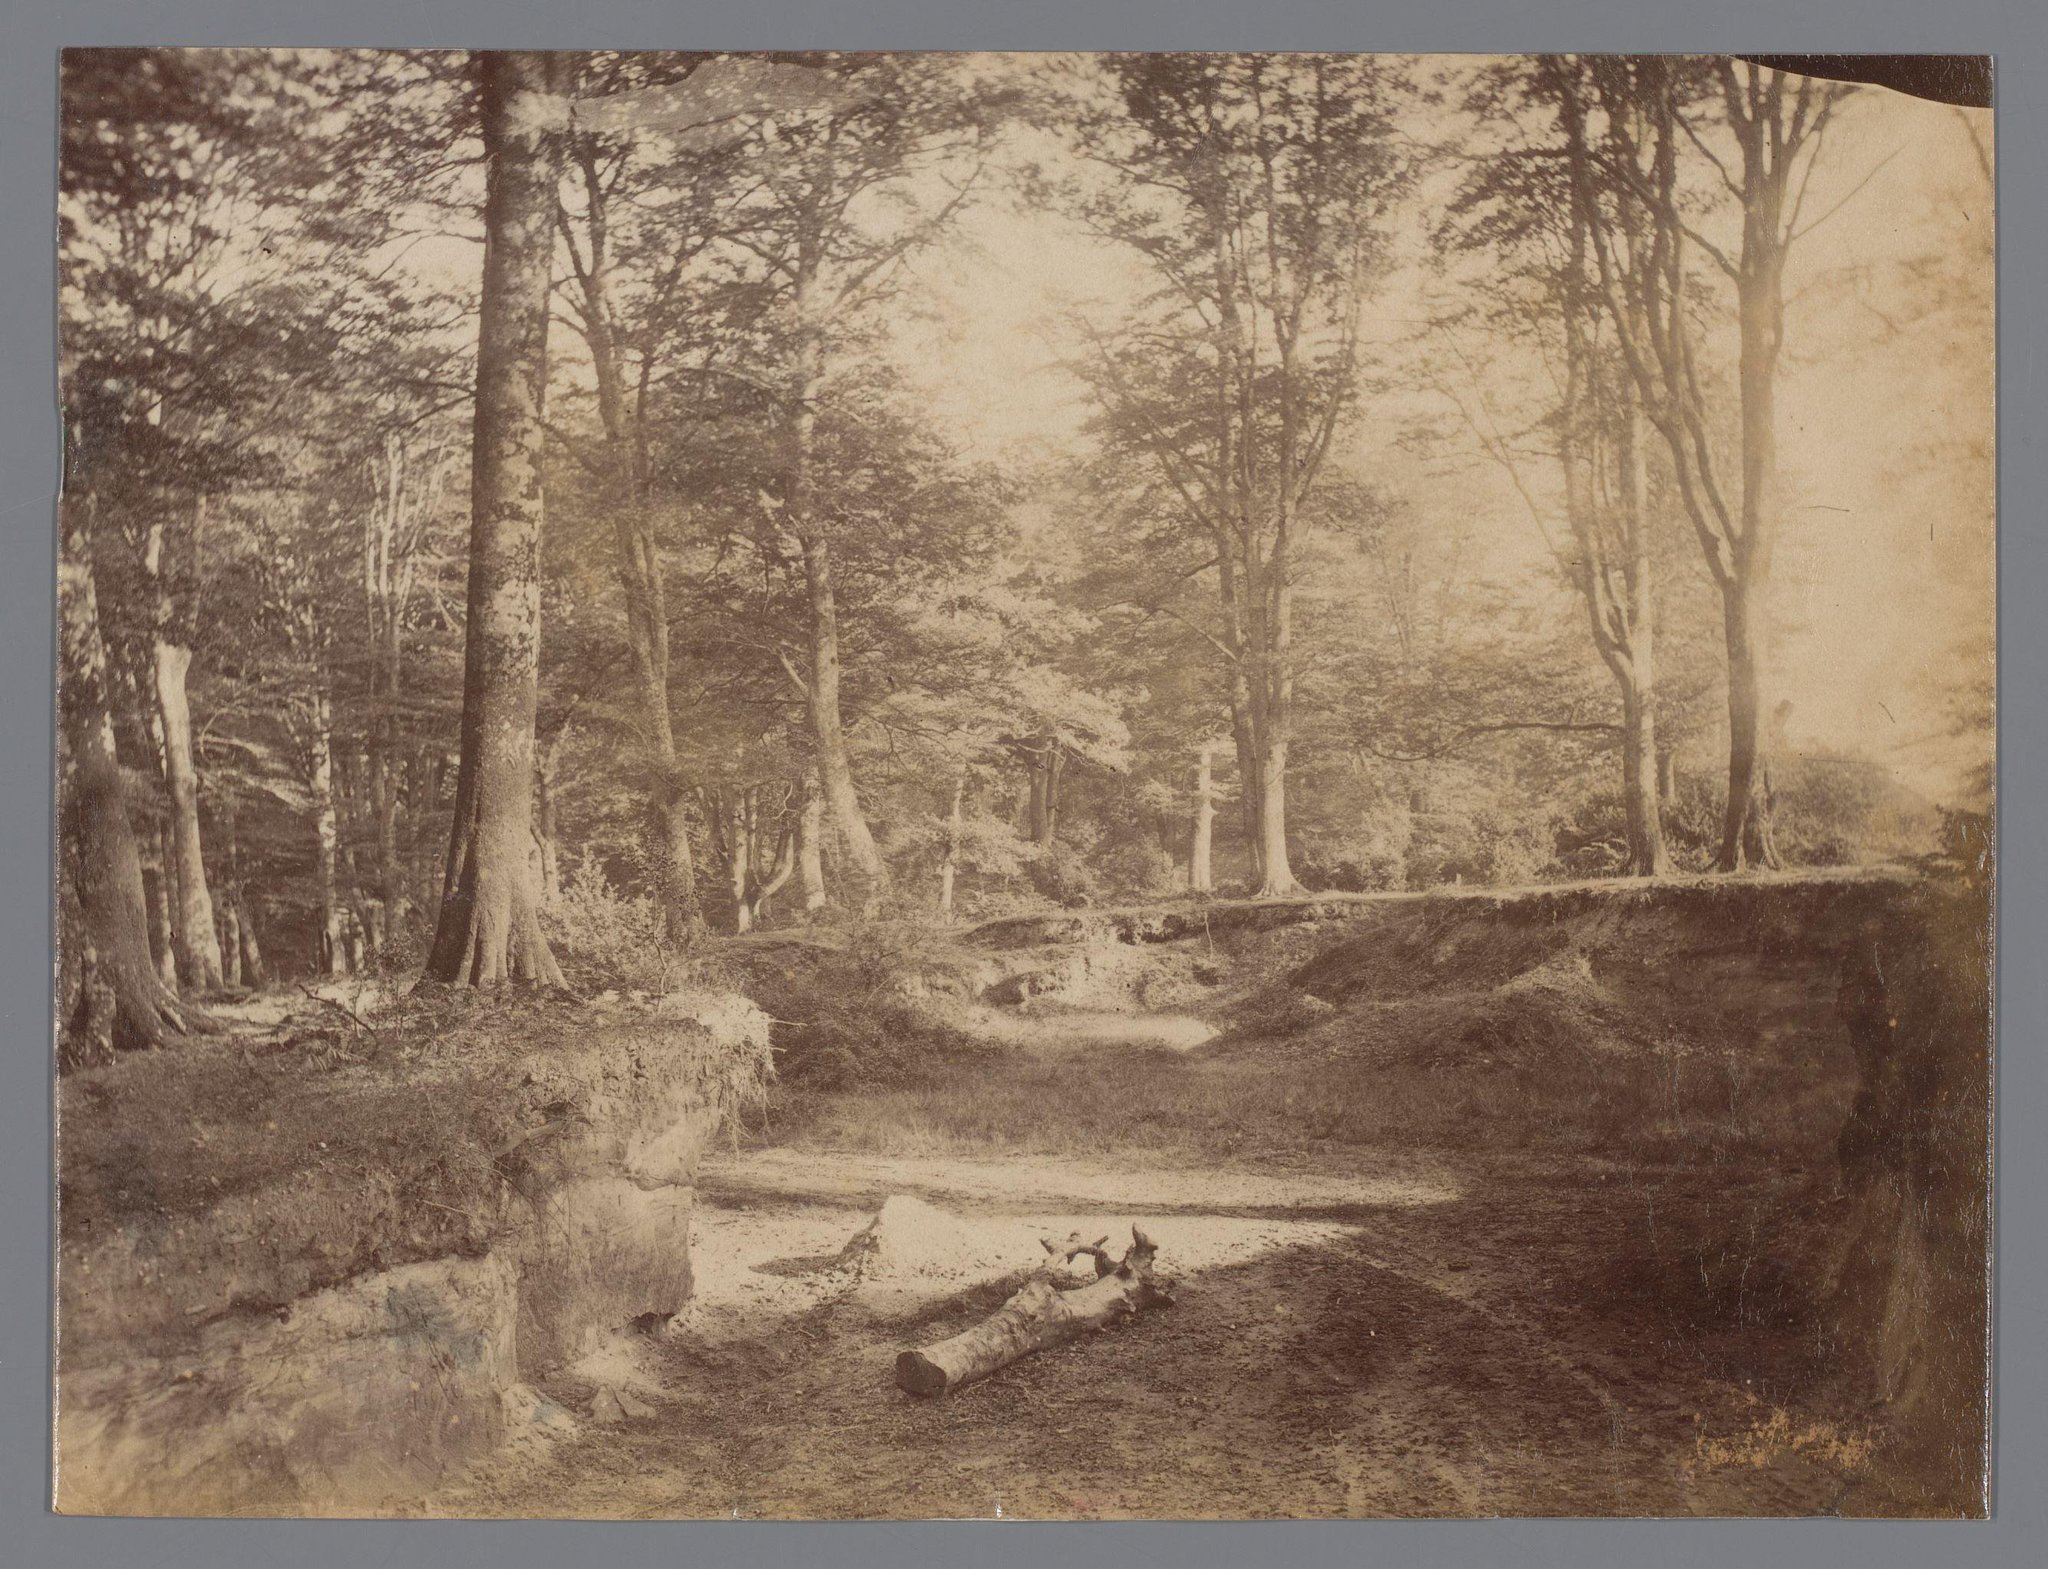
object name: photograph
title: Boslandschap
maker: Anonymous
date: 1875-1890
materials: paper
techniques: albumen print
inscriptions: inscription: ‘Old Sandfort Al[...?] Green’, inscription: ‘M.M.’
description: Boslandschap, met loofbomen. Rond een open plaats op de voorgrond valt zonlicht.